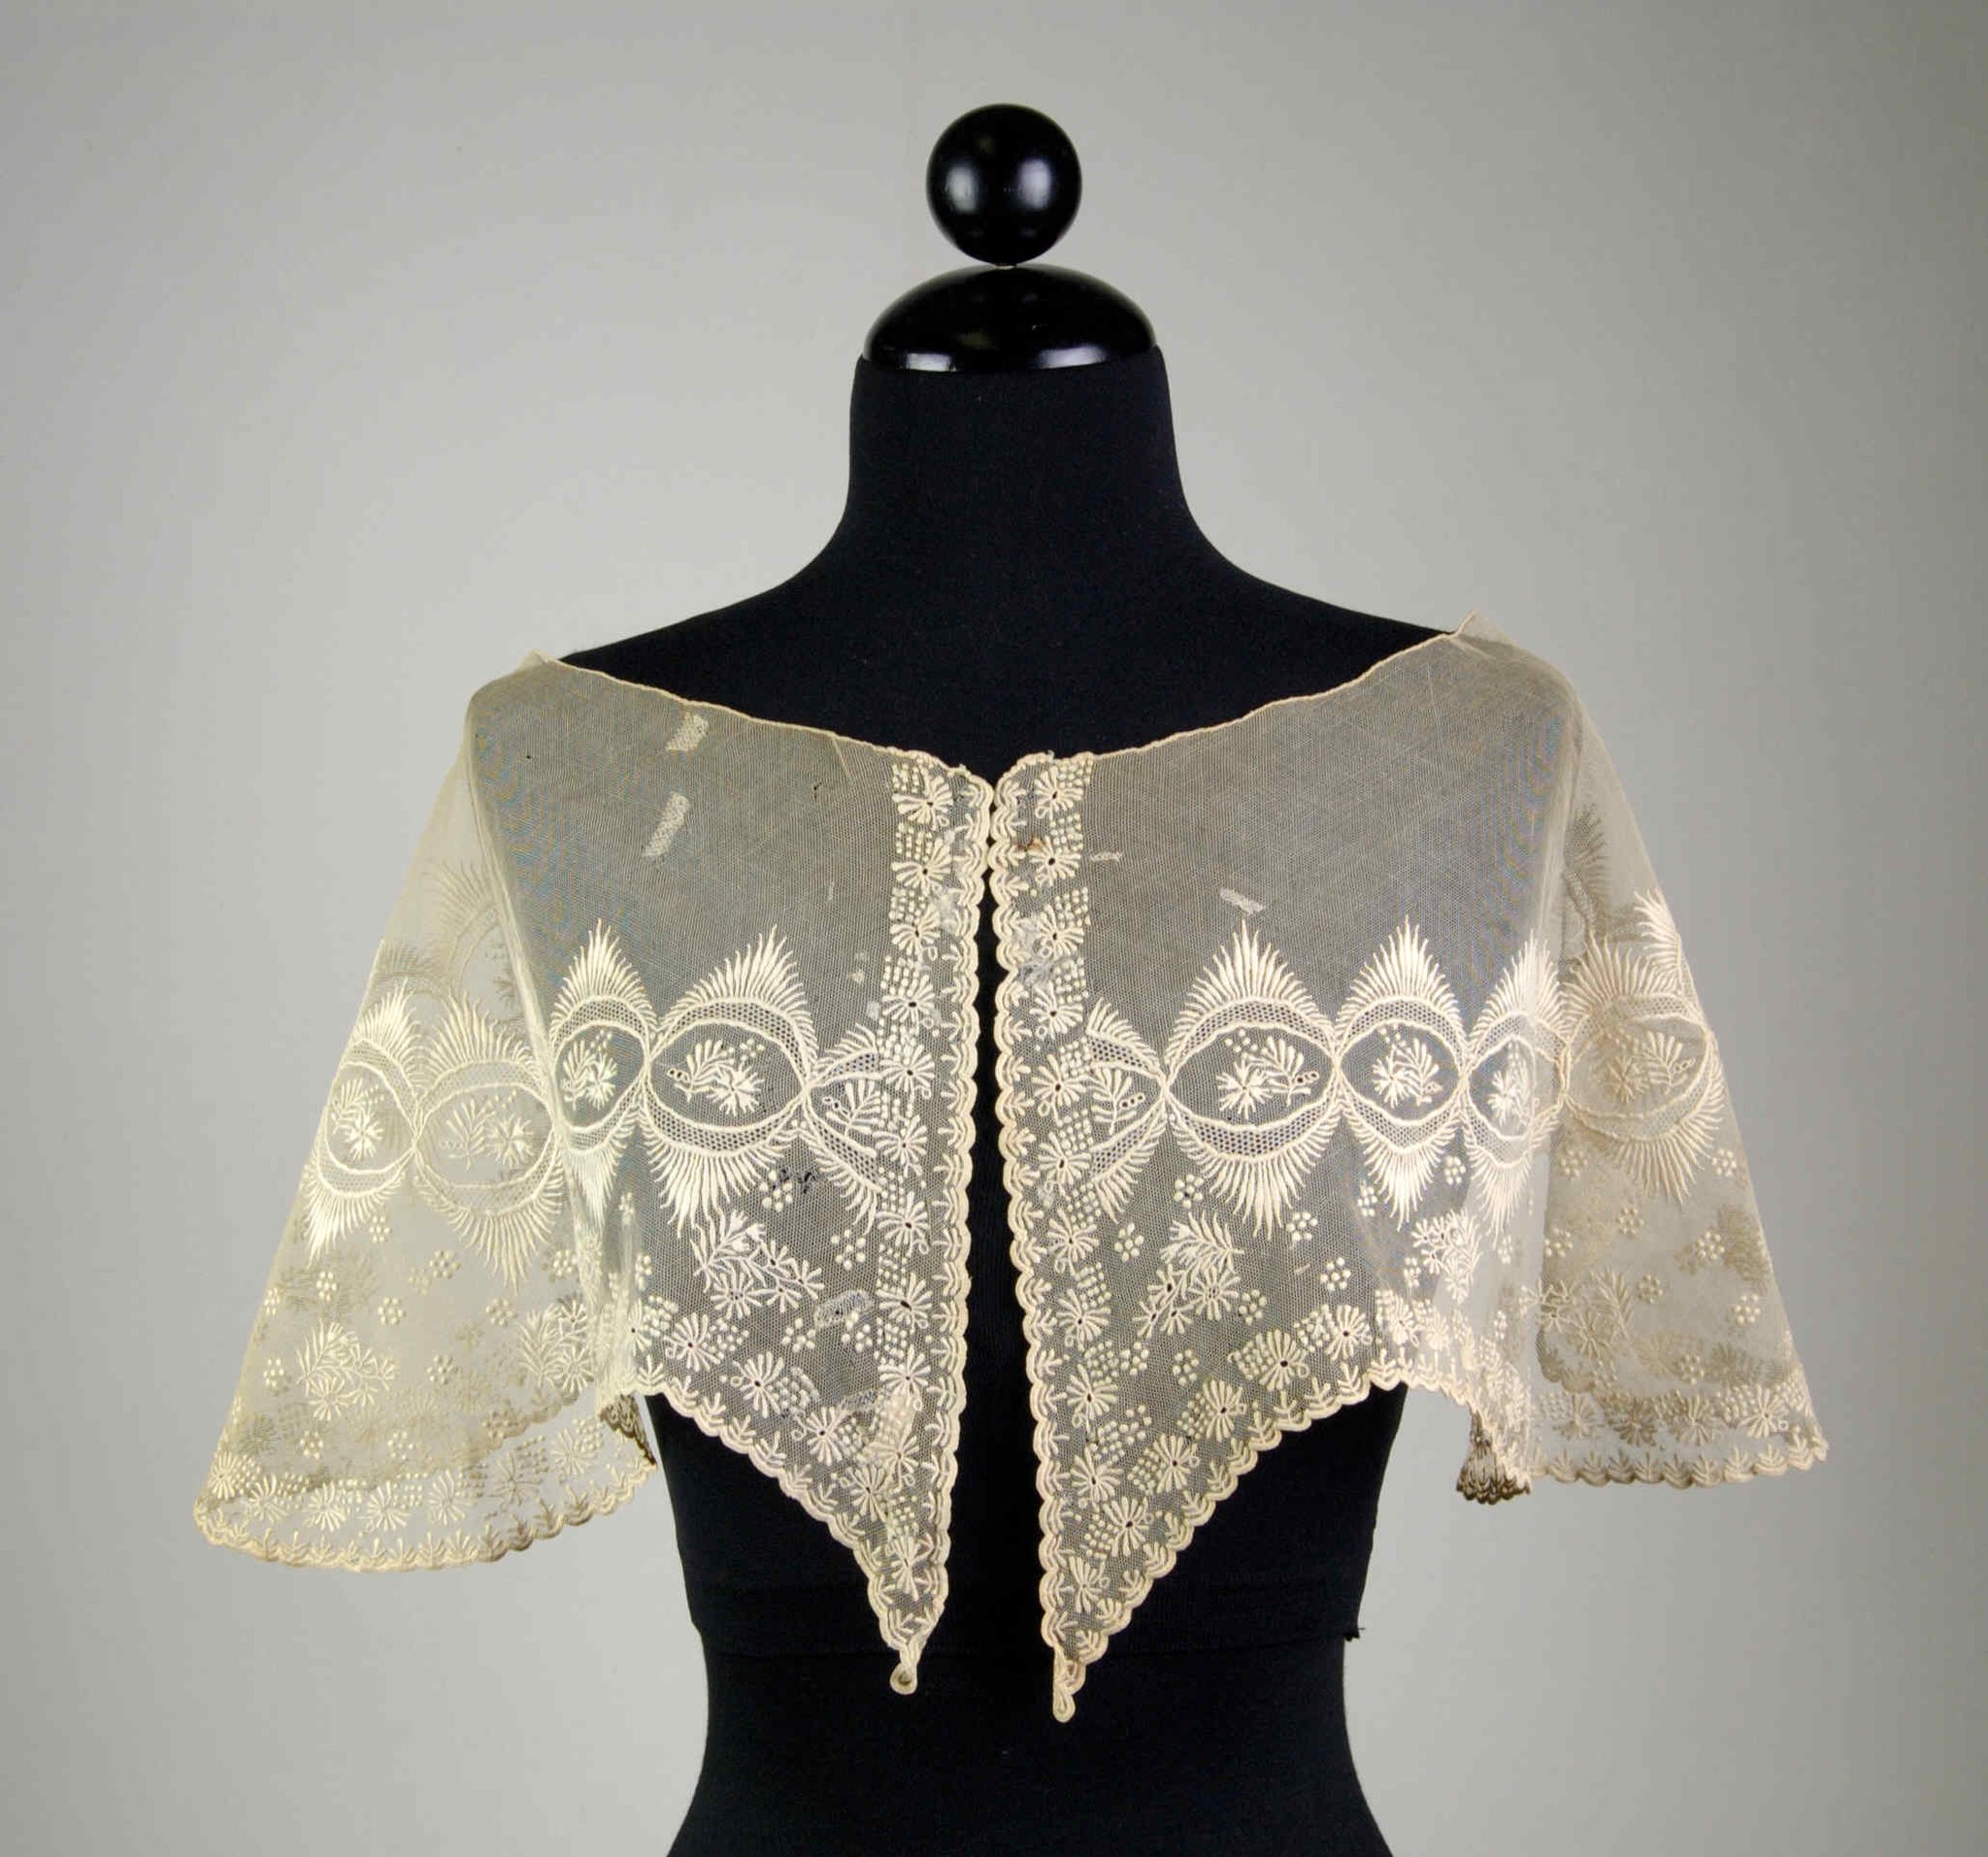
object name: collar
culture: american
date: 1835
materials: cotton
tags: flowers